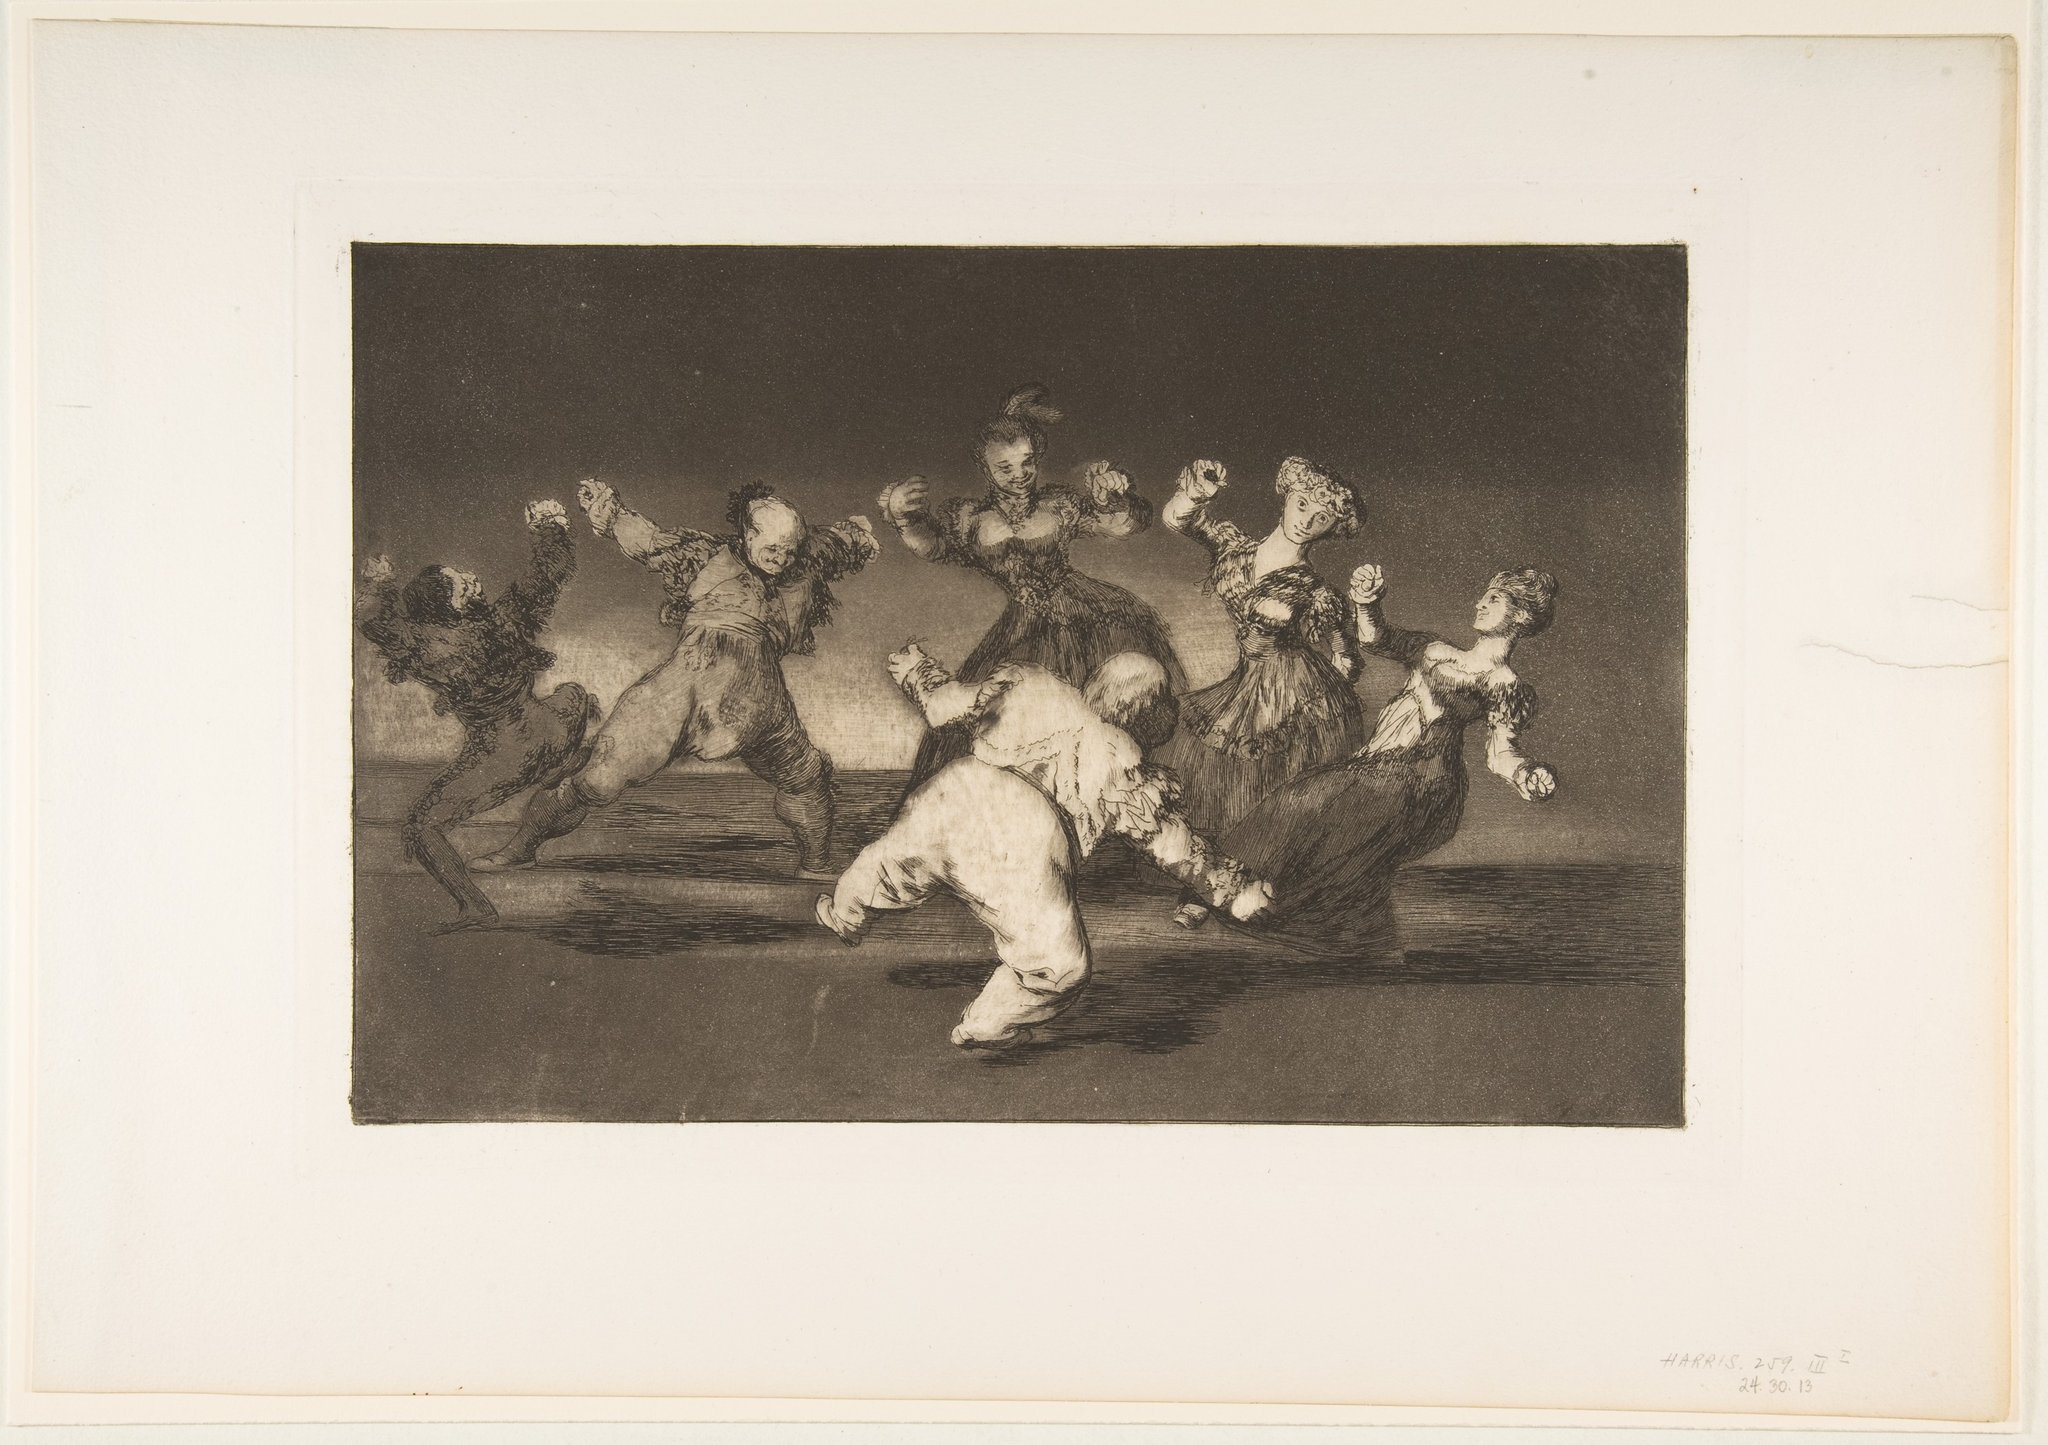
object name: print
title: Merry Folly, from "The Disparates" (Follies / Irrationalities)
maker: goya (francisco de goya y lucientes)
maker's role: artist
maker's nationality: spanish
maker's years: 1746-1828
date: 1815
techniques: aquatint, burnishing, drypoint, etching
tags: men,women,dancing